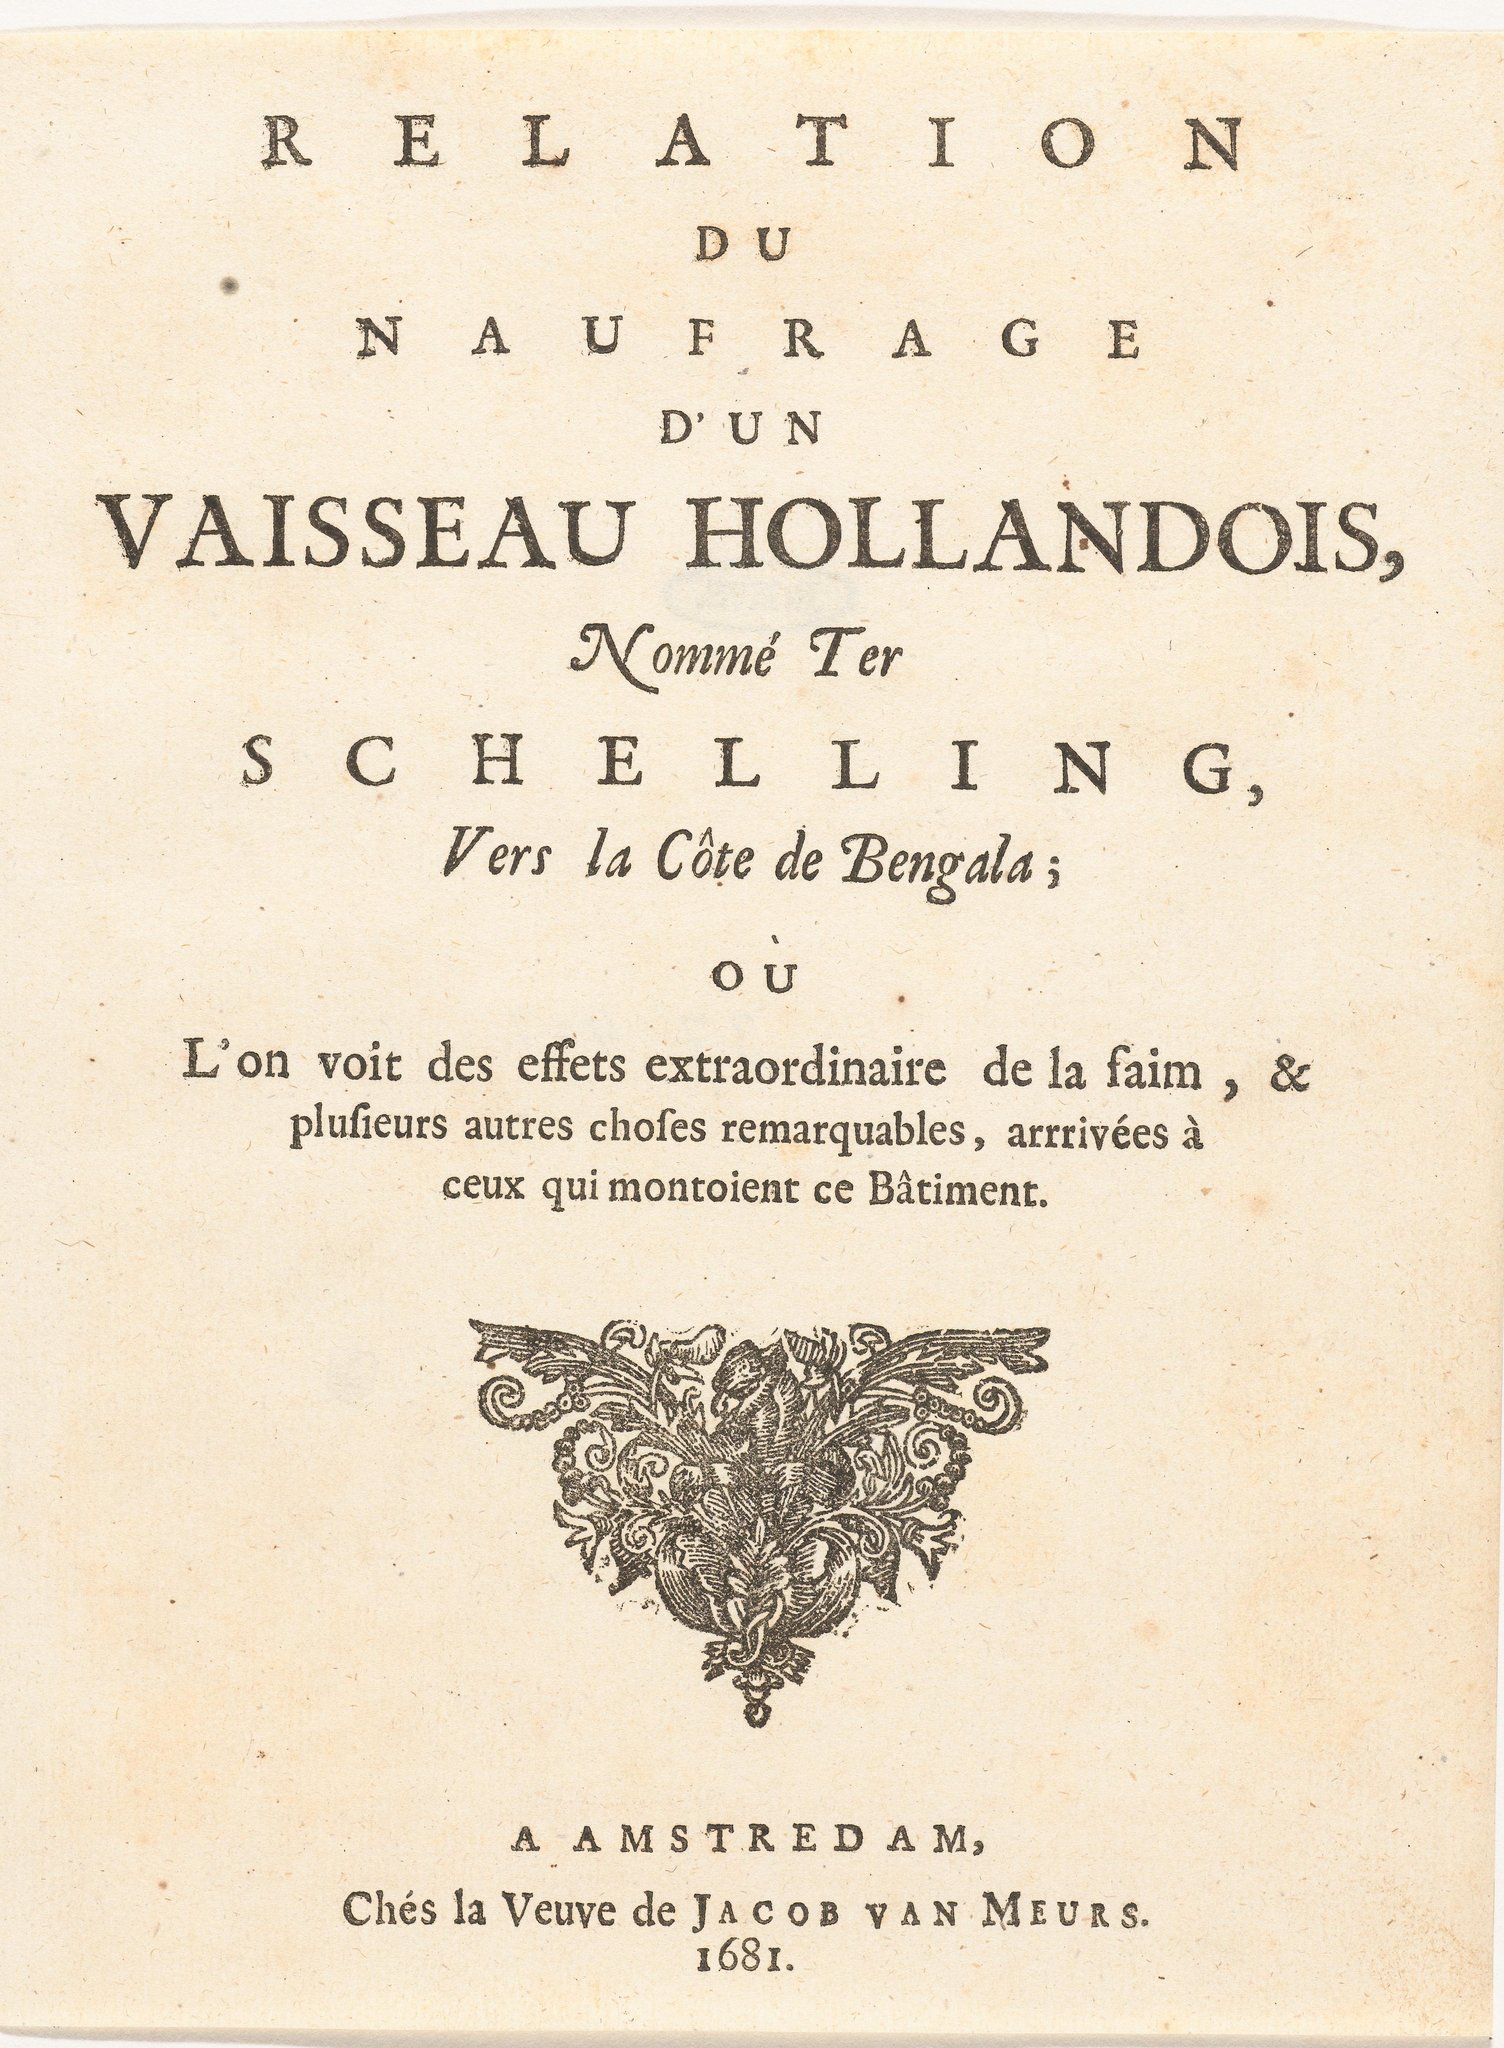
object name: titelblad, titelpagina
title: Titelpagina voor: Relation du naufrage d'un vaisseau hollandais, nommé Terschelling vers la côte de Bengale, Amsterdam: 1681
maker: weduwe jacob van meurs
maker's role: publisher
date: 1681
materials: paper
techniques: letterpress printing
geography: amsterdam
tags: title-page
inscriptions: collector's mark: Lugt 2228, collector's mark: Lugt 2760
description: Titelpagina voor: [Frans Jansz van der Heiden], Relation du naufrage d'un vaisseau hollandois, nommé Ter Schelling, vers la côte de Bengala. Amsterdam, wed. Jacob van Meurs, 1681.